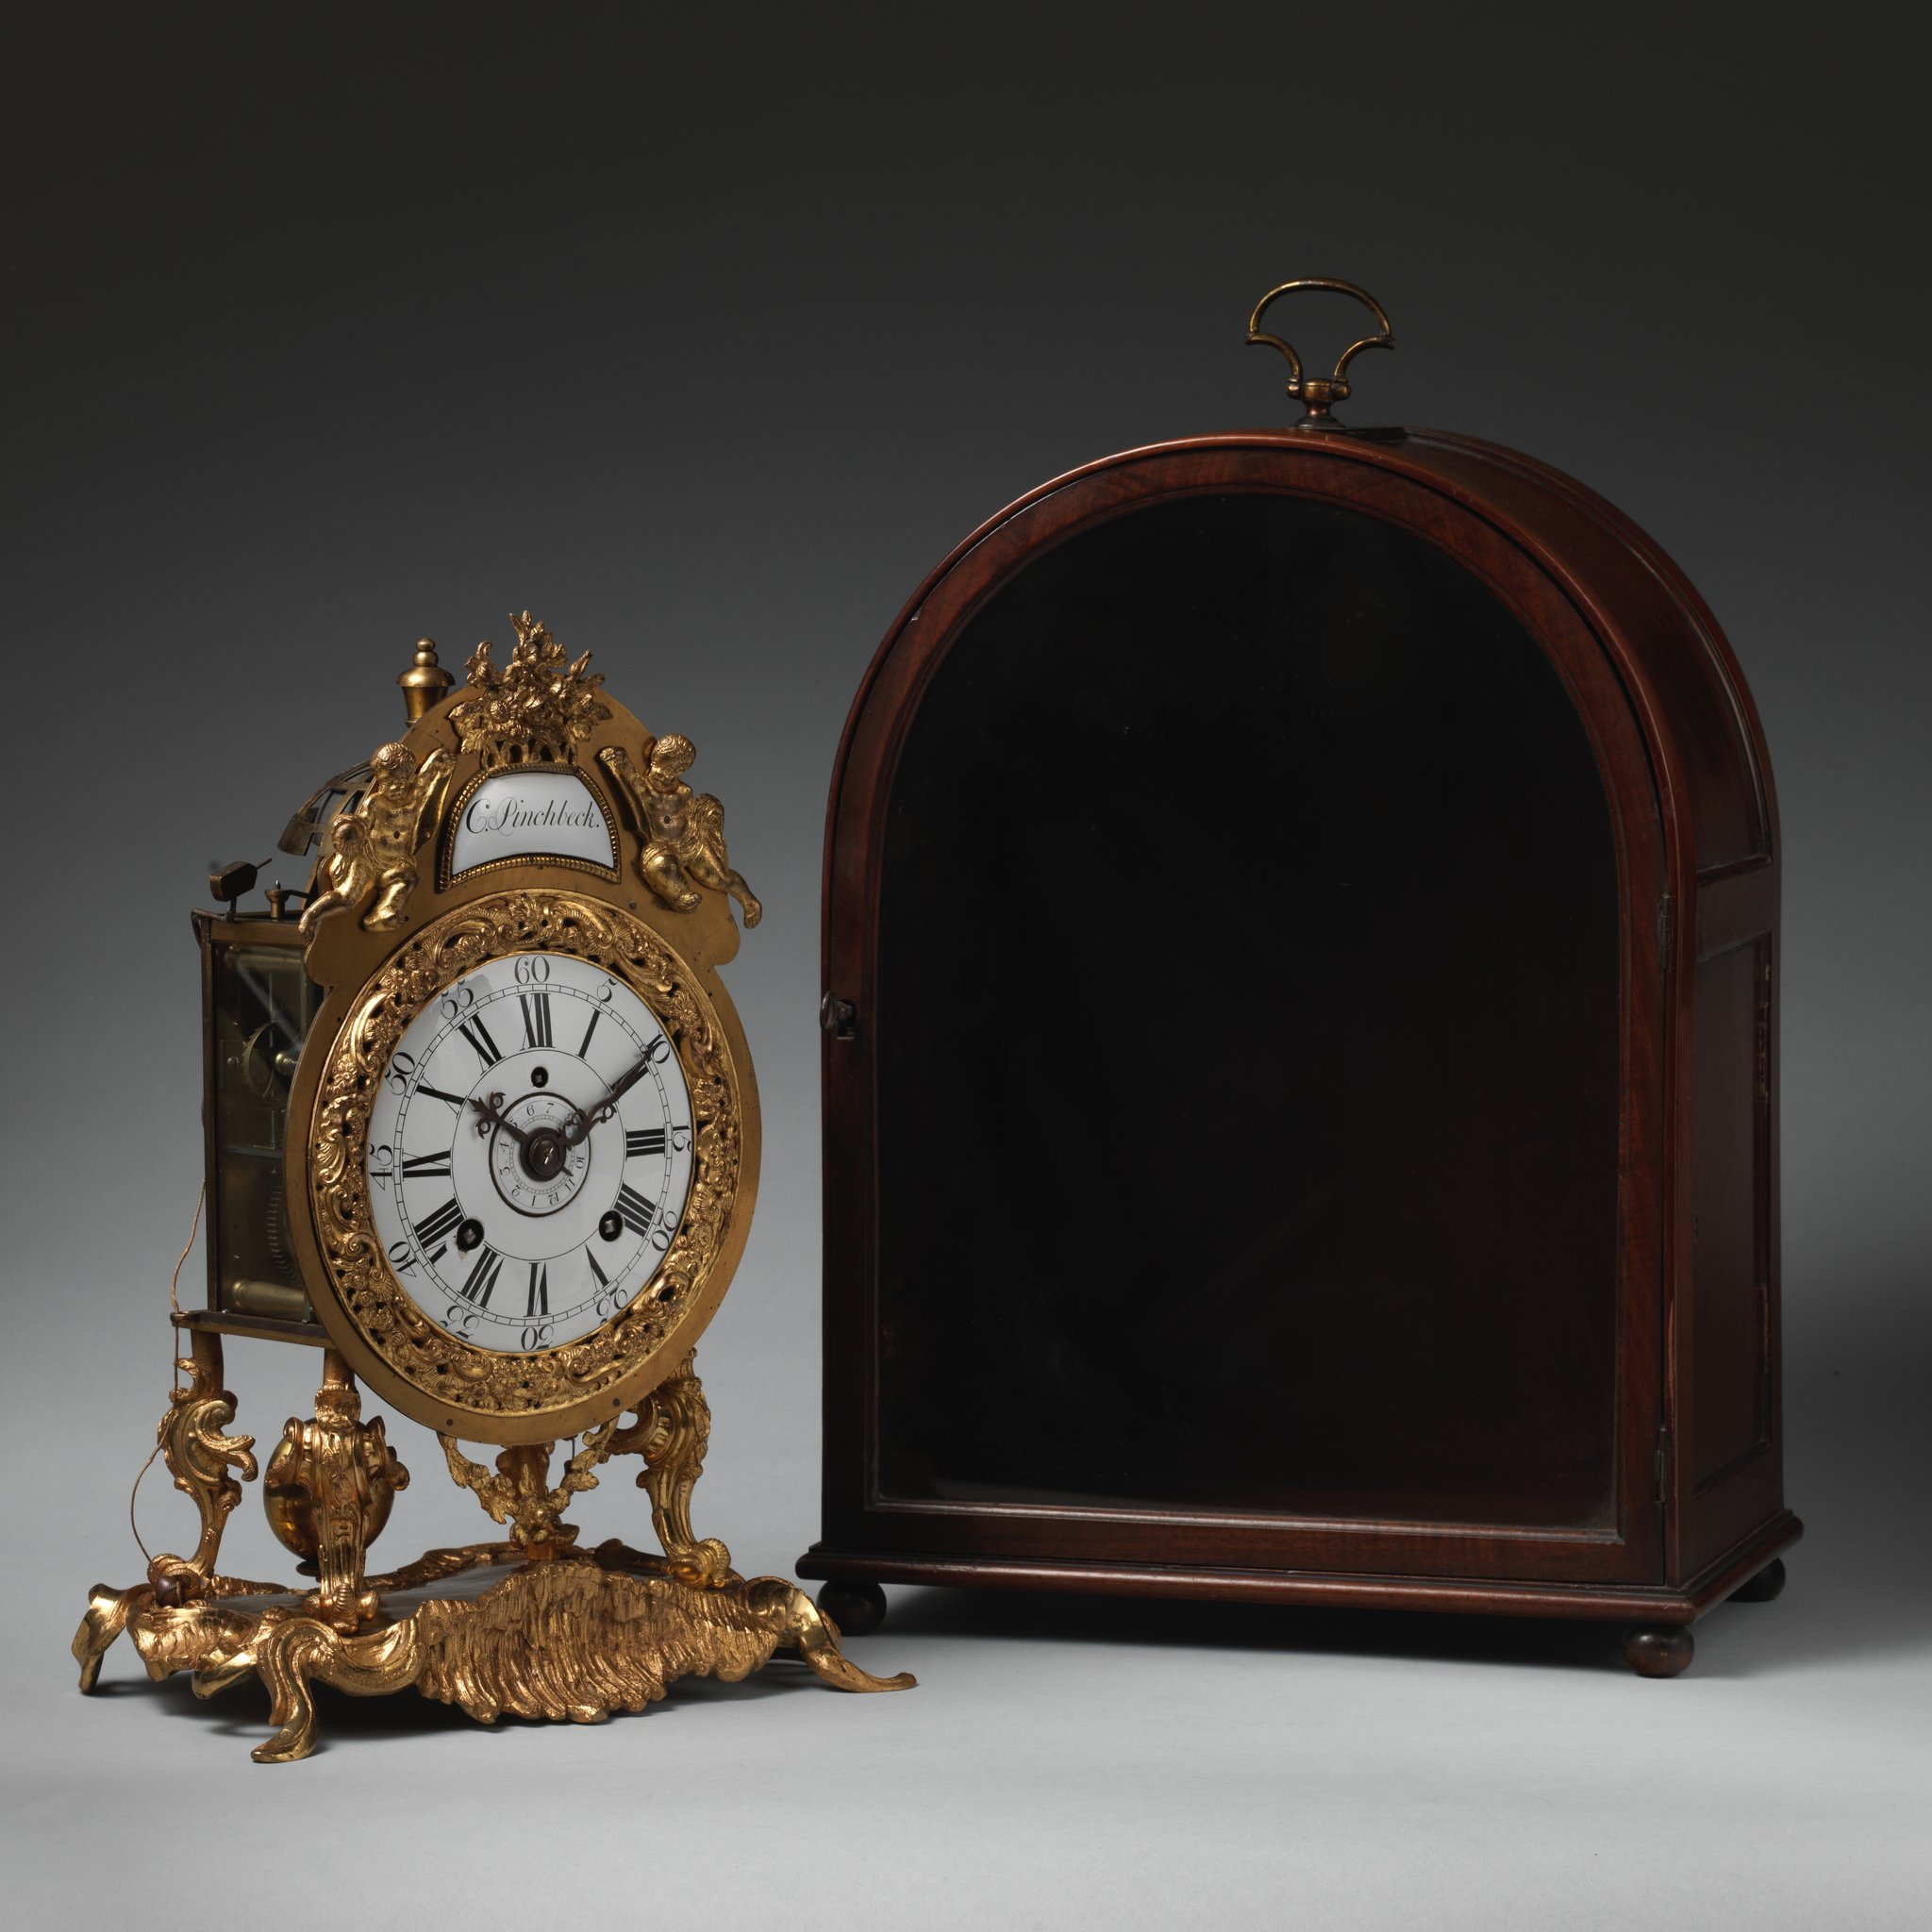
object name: table or bracket clock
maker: christopher pinchbeck ii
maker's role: maker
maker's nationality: british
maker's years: 1683-1783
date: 1775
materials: wood, metal